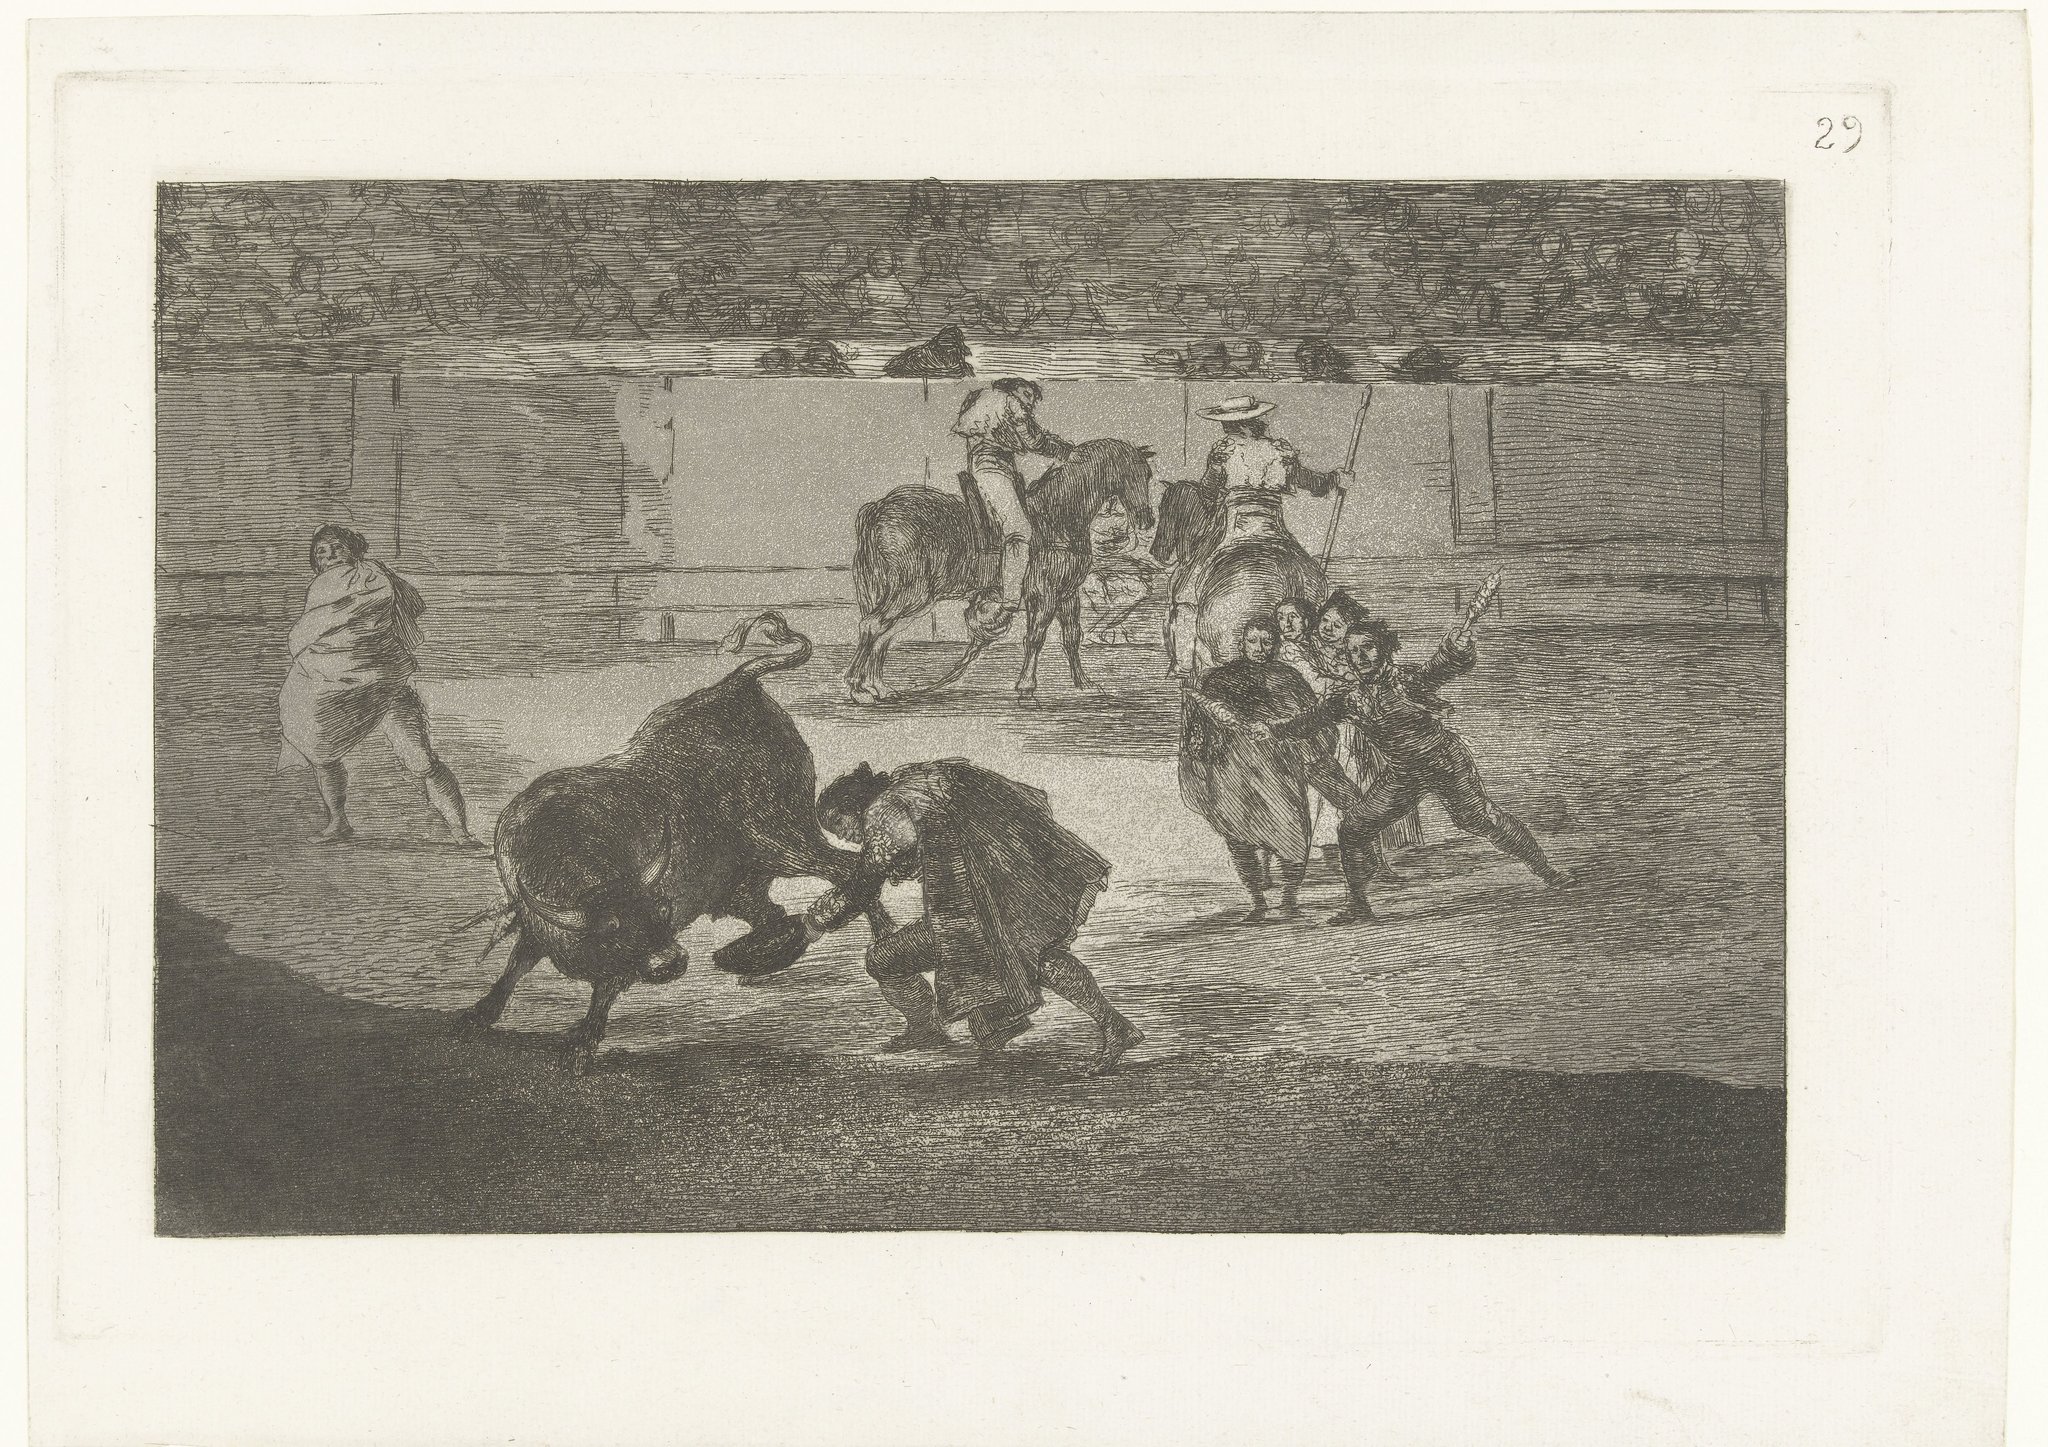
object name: print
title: La Tauromaquia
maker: francisco de goya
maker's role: draughtsman, painter, print maker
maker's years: 1746-1828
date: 1811-1816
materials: paper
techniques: aquatint, drypoint, etching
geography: spain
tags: sevilla, bullfight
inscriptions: collector's mark: Lugt 805b, collector's mark: Lugt 2228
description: De arena met twee picadors en een aantal mannen te voet. Op de voorgrond de torero (stierenvechter) Pepe-Hillo die voor de stier zijn hoed afneemt.